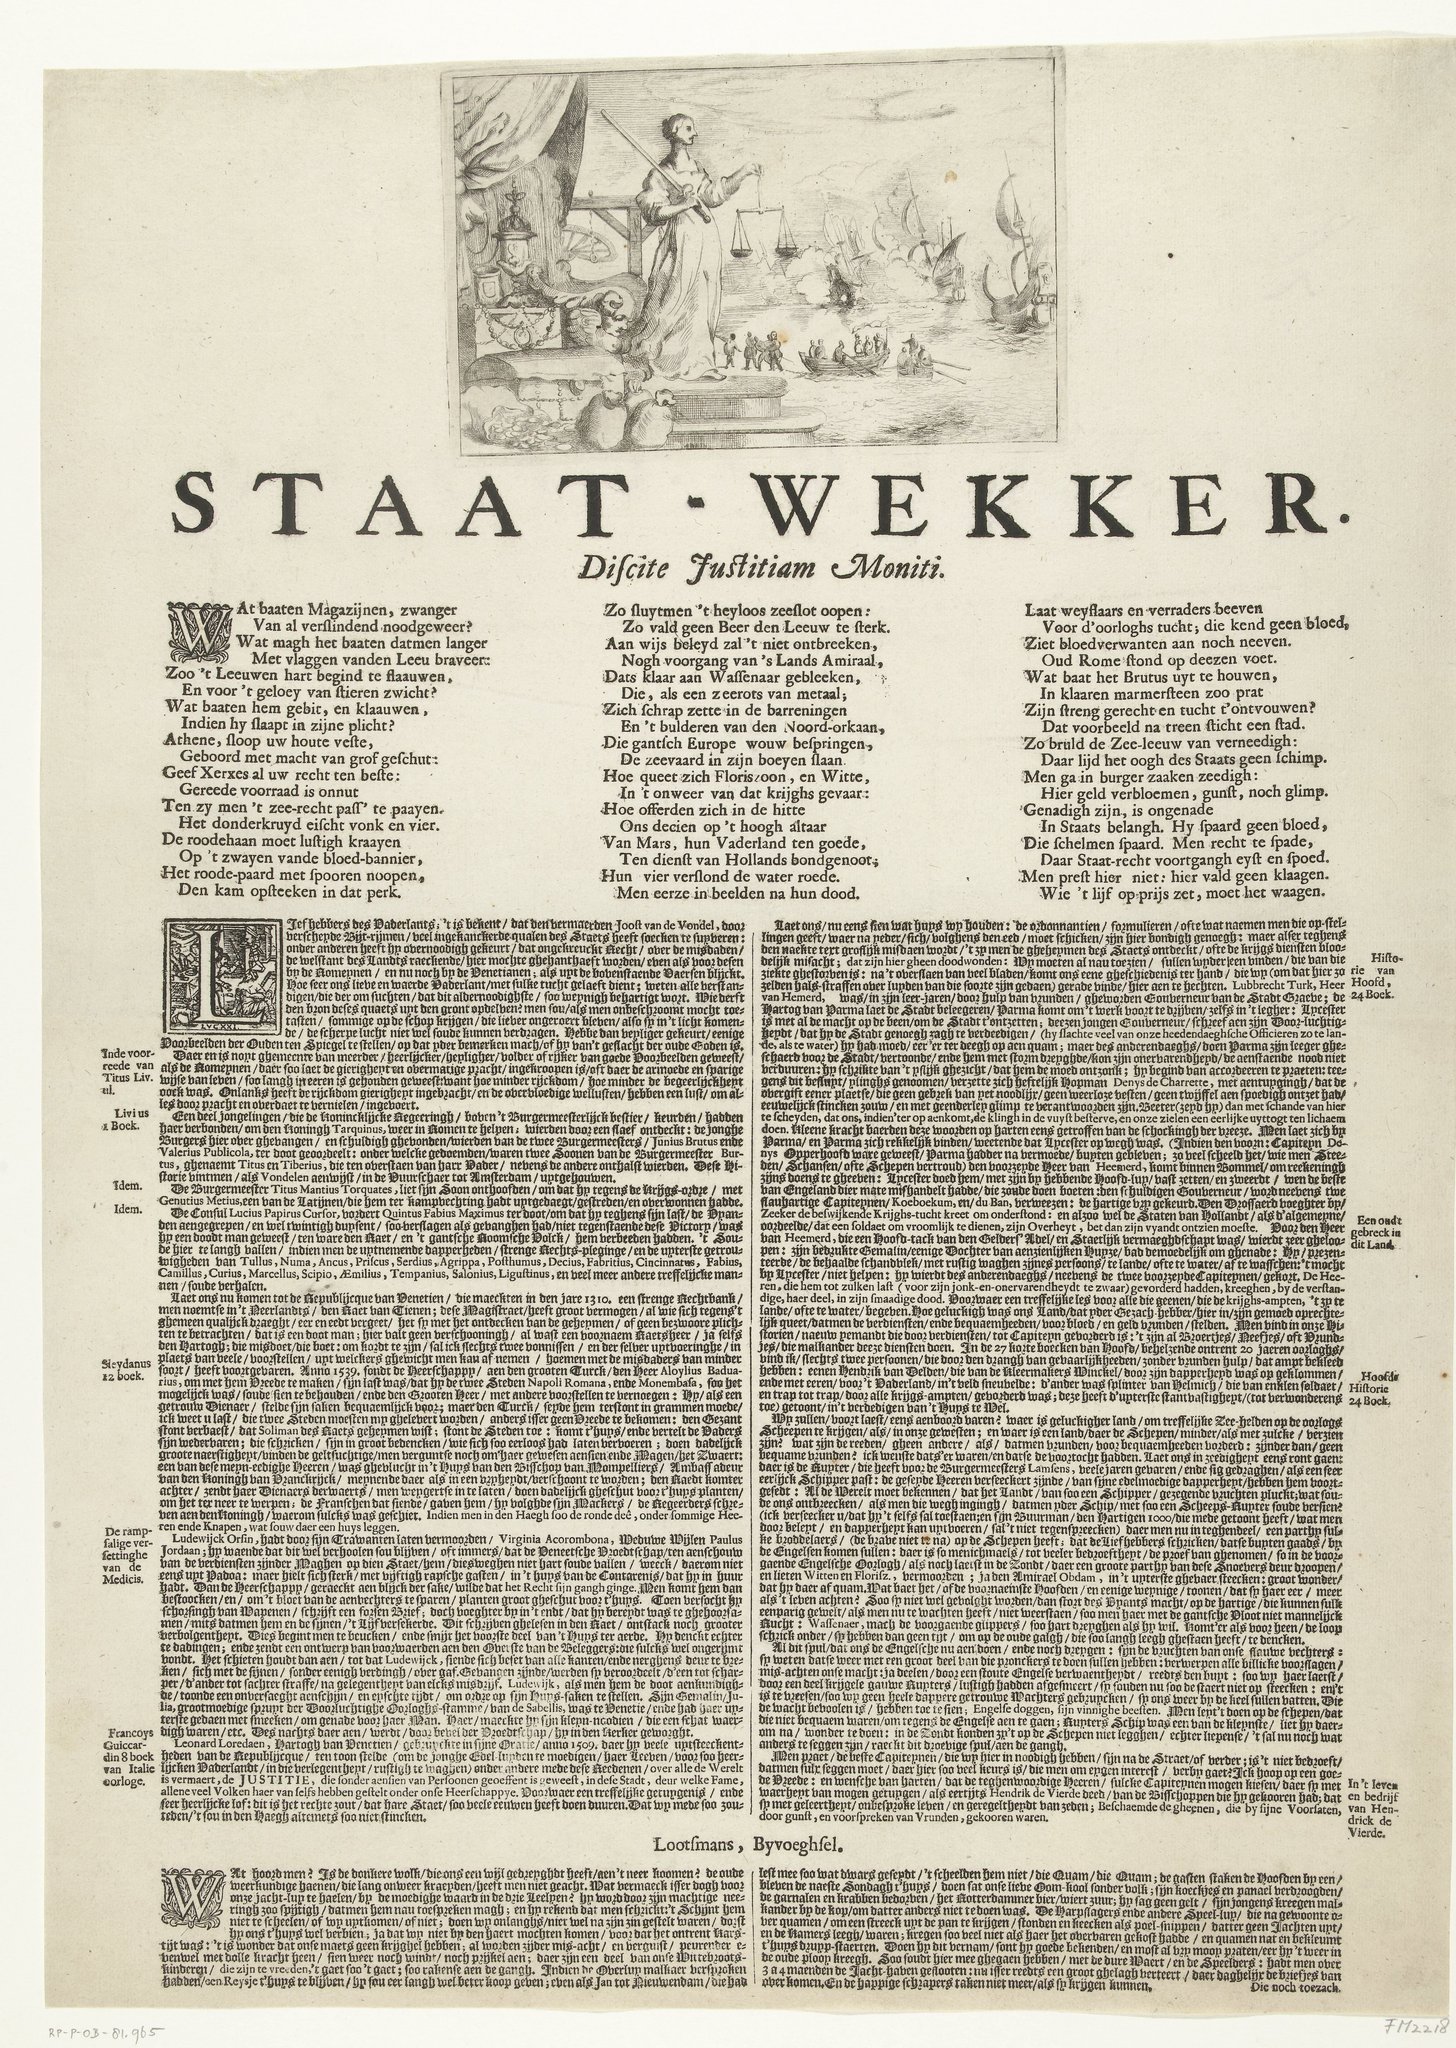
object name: print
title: Aanklacht tegen de binnenlandse flauwheid en verraad, ca. 1665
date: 1660-1669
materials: paper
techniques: etching, letterpress printing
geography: northern netherlands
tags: justice, 'justitia'; 'giustitia divina' (ripa) ~ one of the four cardinal virtues, battle (+ naval force), battle of lowestoft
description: Blad met een aanklacht tegen de flauwheid en verraad in de Republiek, waarschijnlijk na het verlies in de slag bij Lowestoft, 1665. Een ongeblinddoekte Justitia met zwaard en weegschalen staande voor een troon overladen met rijkdommen, op de achtergrond een zeeslag. Onder de plaat een vers van Vondel (uit 1658) in drie kolommen en de historische aanklacht in twee kolommen.